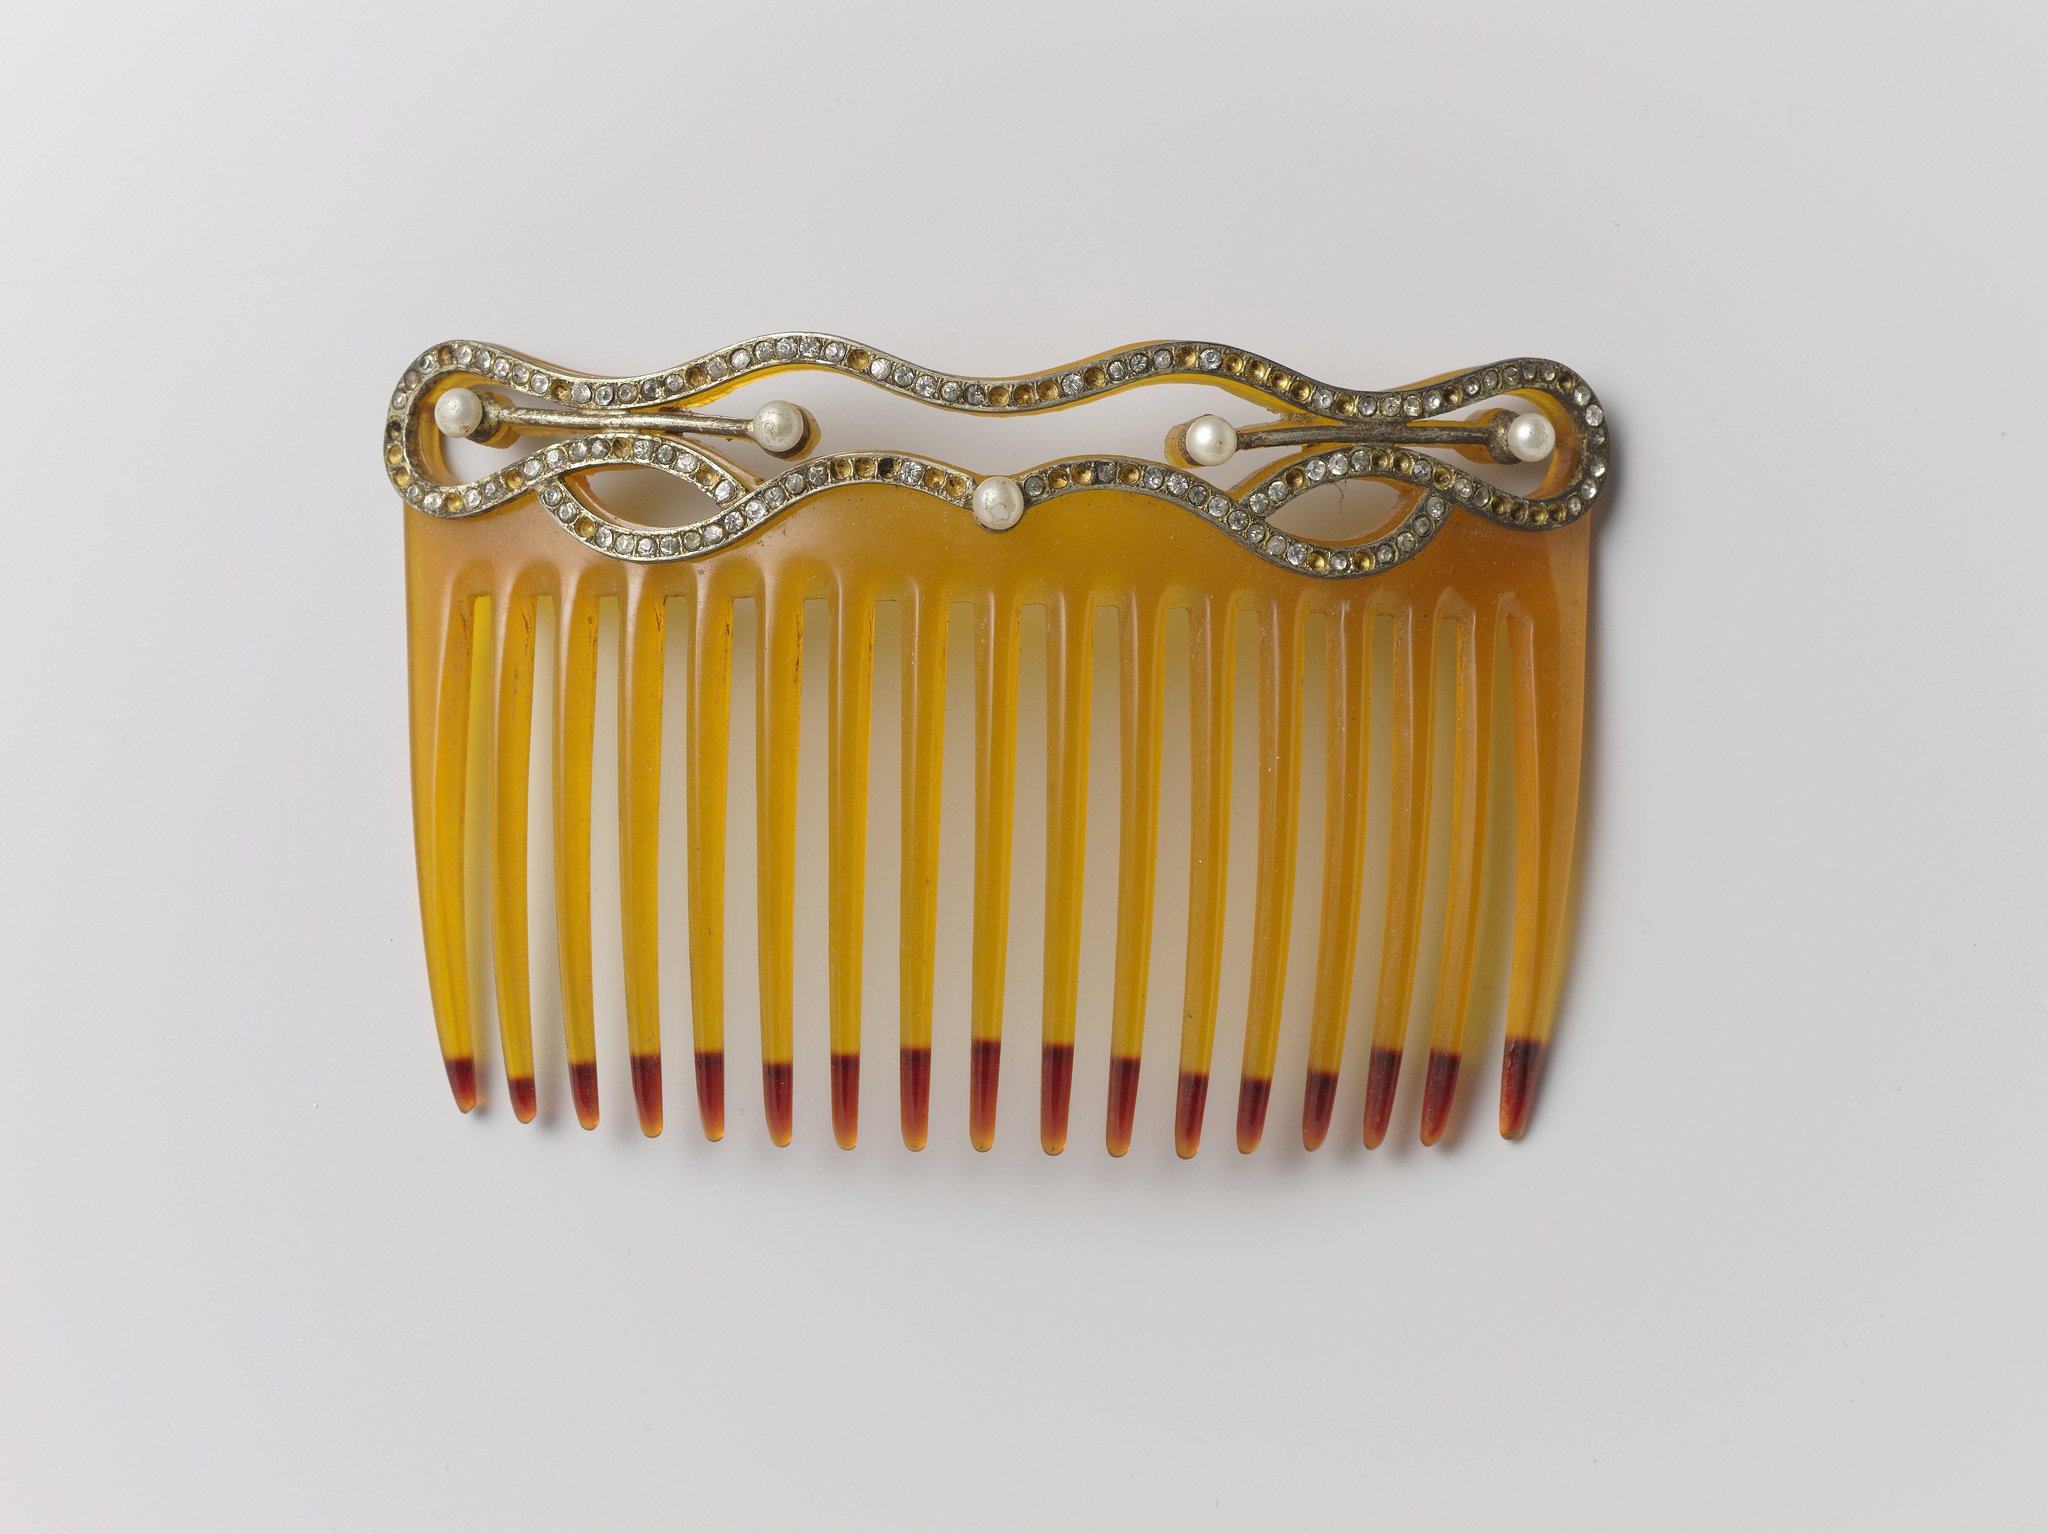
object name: comb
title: Haarkam van kunststof, met rug waarop parels en stras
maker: Anonymous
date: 1875-1900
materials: celluloid, plastic, metal, paste, pearl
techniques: filing, inlay, polish, pressing, sawing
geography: netherlands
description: Haarkam van oranjegele kunststof, met sierlijke rug, afgezet met vijf parels en stras in metaal. Zeventien tanden, met rode uiteinden.